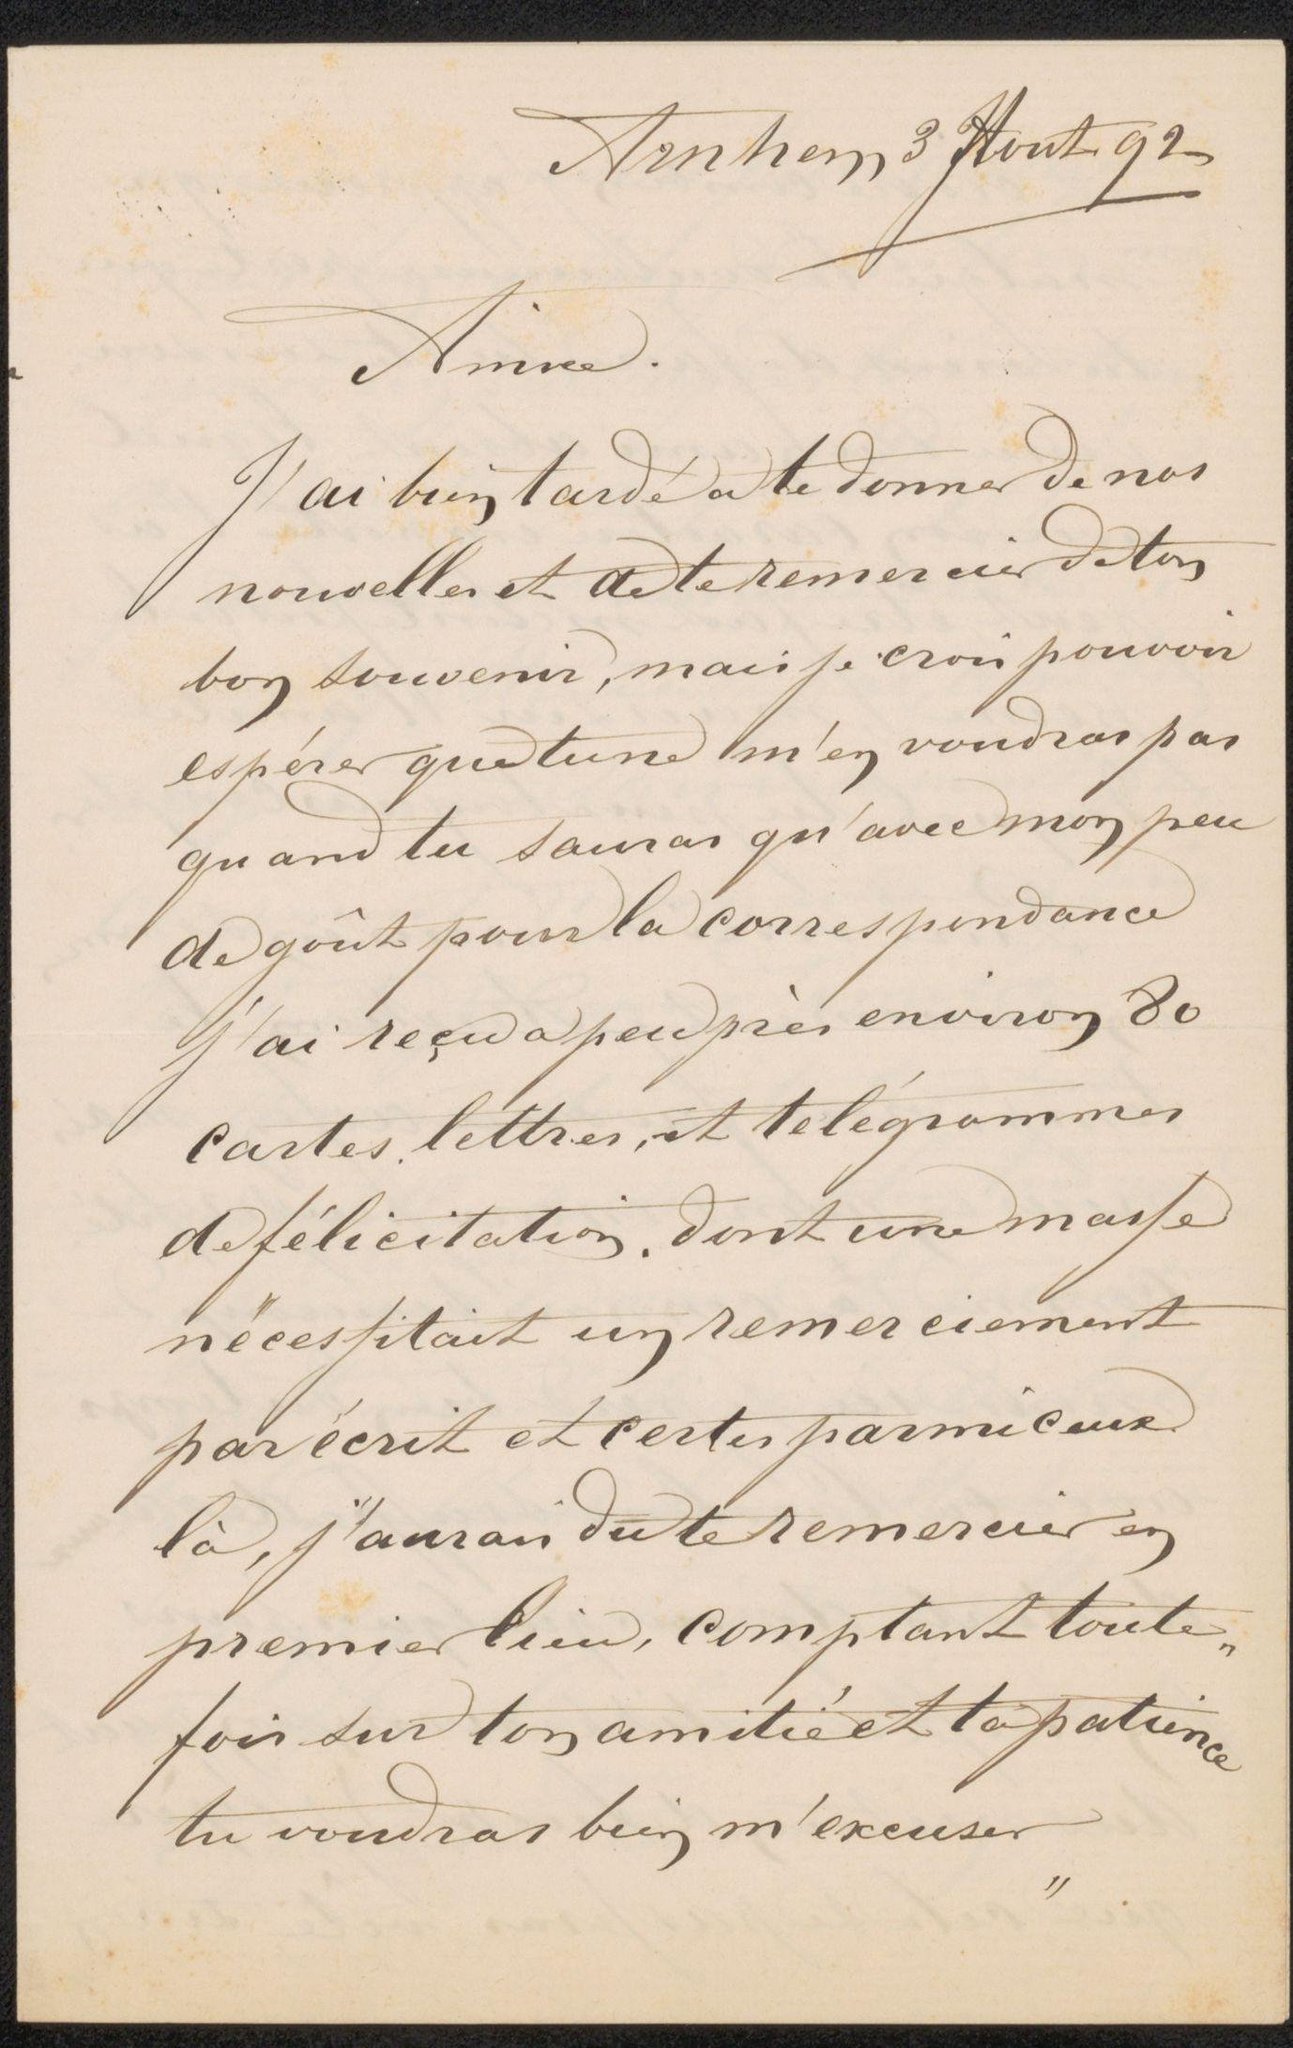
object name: letter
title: Brief aan August Allebé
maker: louis chantal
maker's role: draughtsman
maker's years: 1822-1899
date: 1892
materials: ink, paper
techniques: pen, writing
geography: arnhem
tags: august allebé, arnhem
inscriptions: watermark